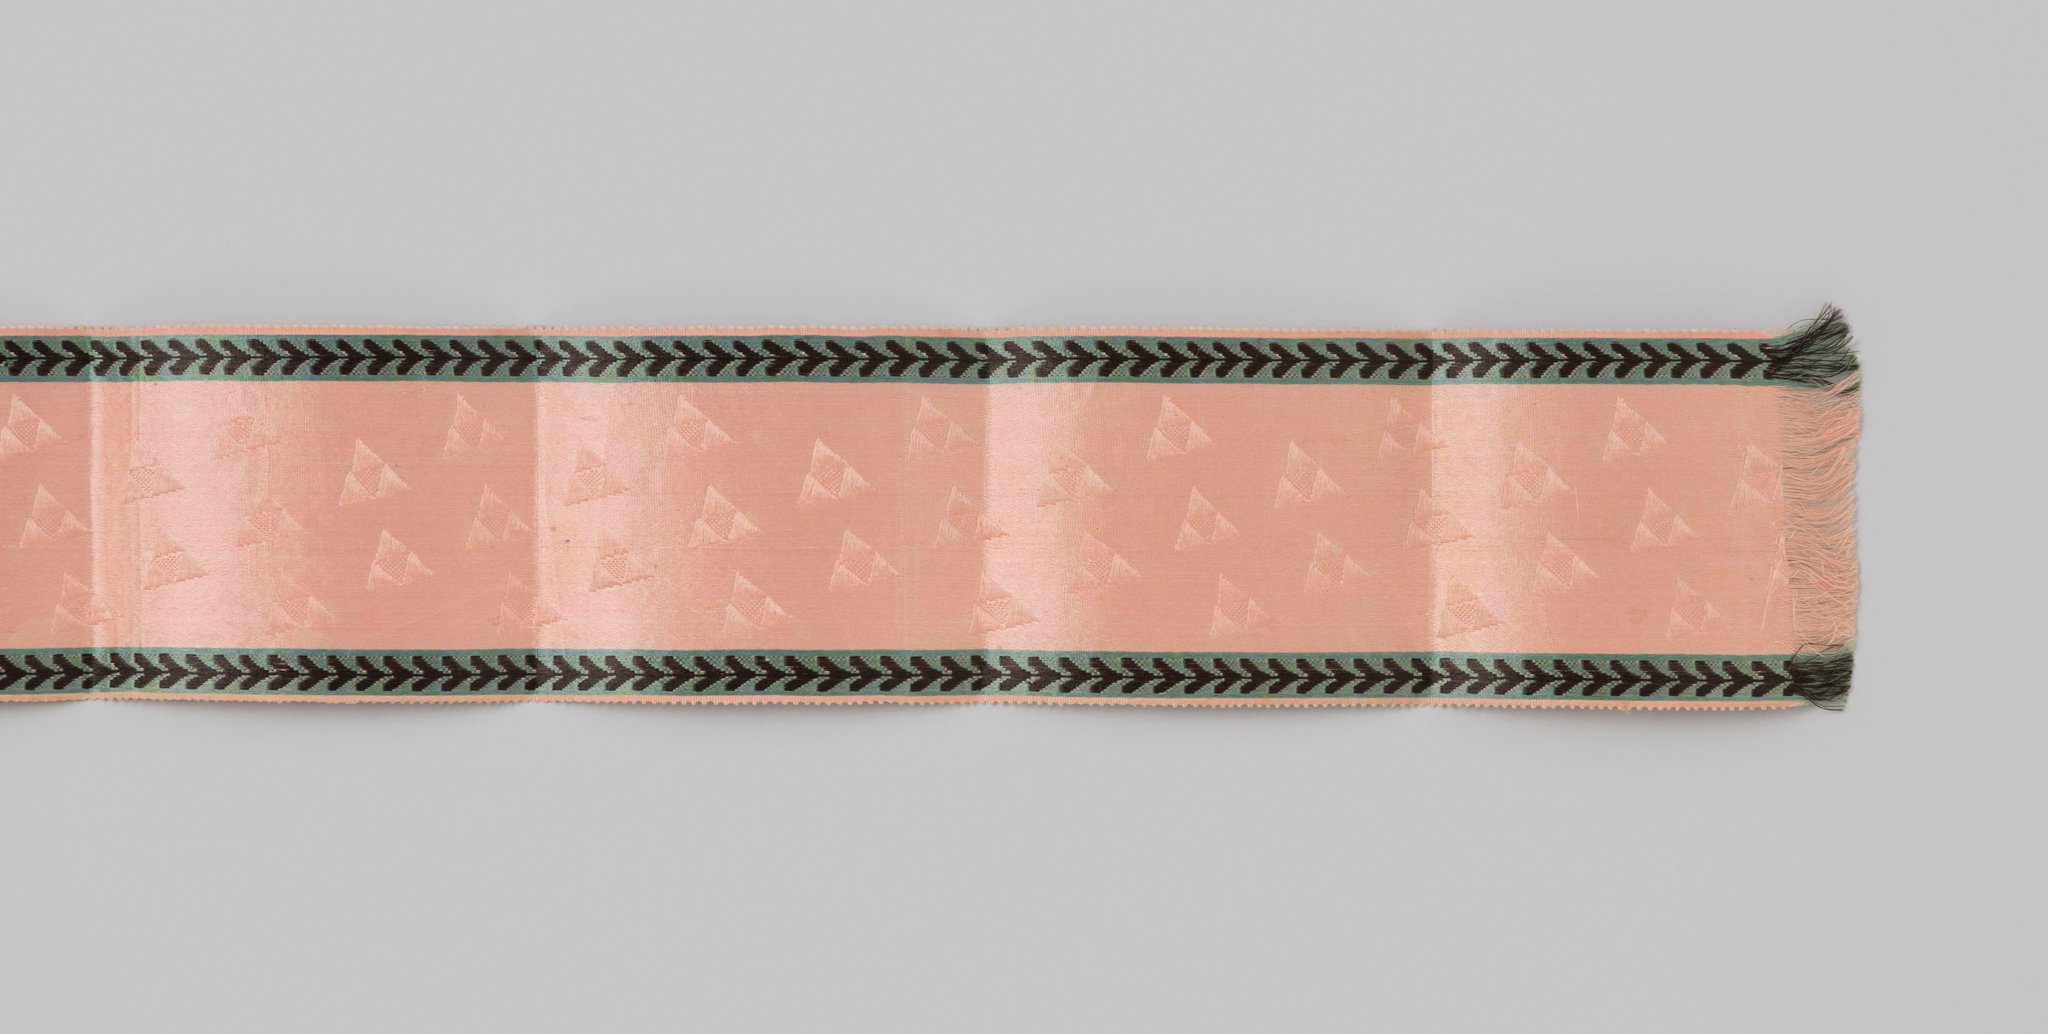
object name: womenswear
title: Lint van zalmroze zijde, met een strooimotief van ingeweven driehoeken; langs de randen loopt een groene bies waarin een gestileerde bladrank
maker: Anonymous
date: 1800-1815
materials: silk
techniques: weave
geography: netherlands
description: Lint van zalmroze zijde, met een strooimotief van ingeweven driehoeken. Langs de randen loopt een groene bies waarin een gestileerde bladrank. Mogelijk dameskleding, mogelijk een strikceintuur.